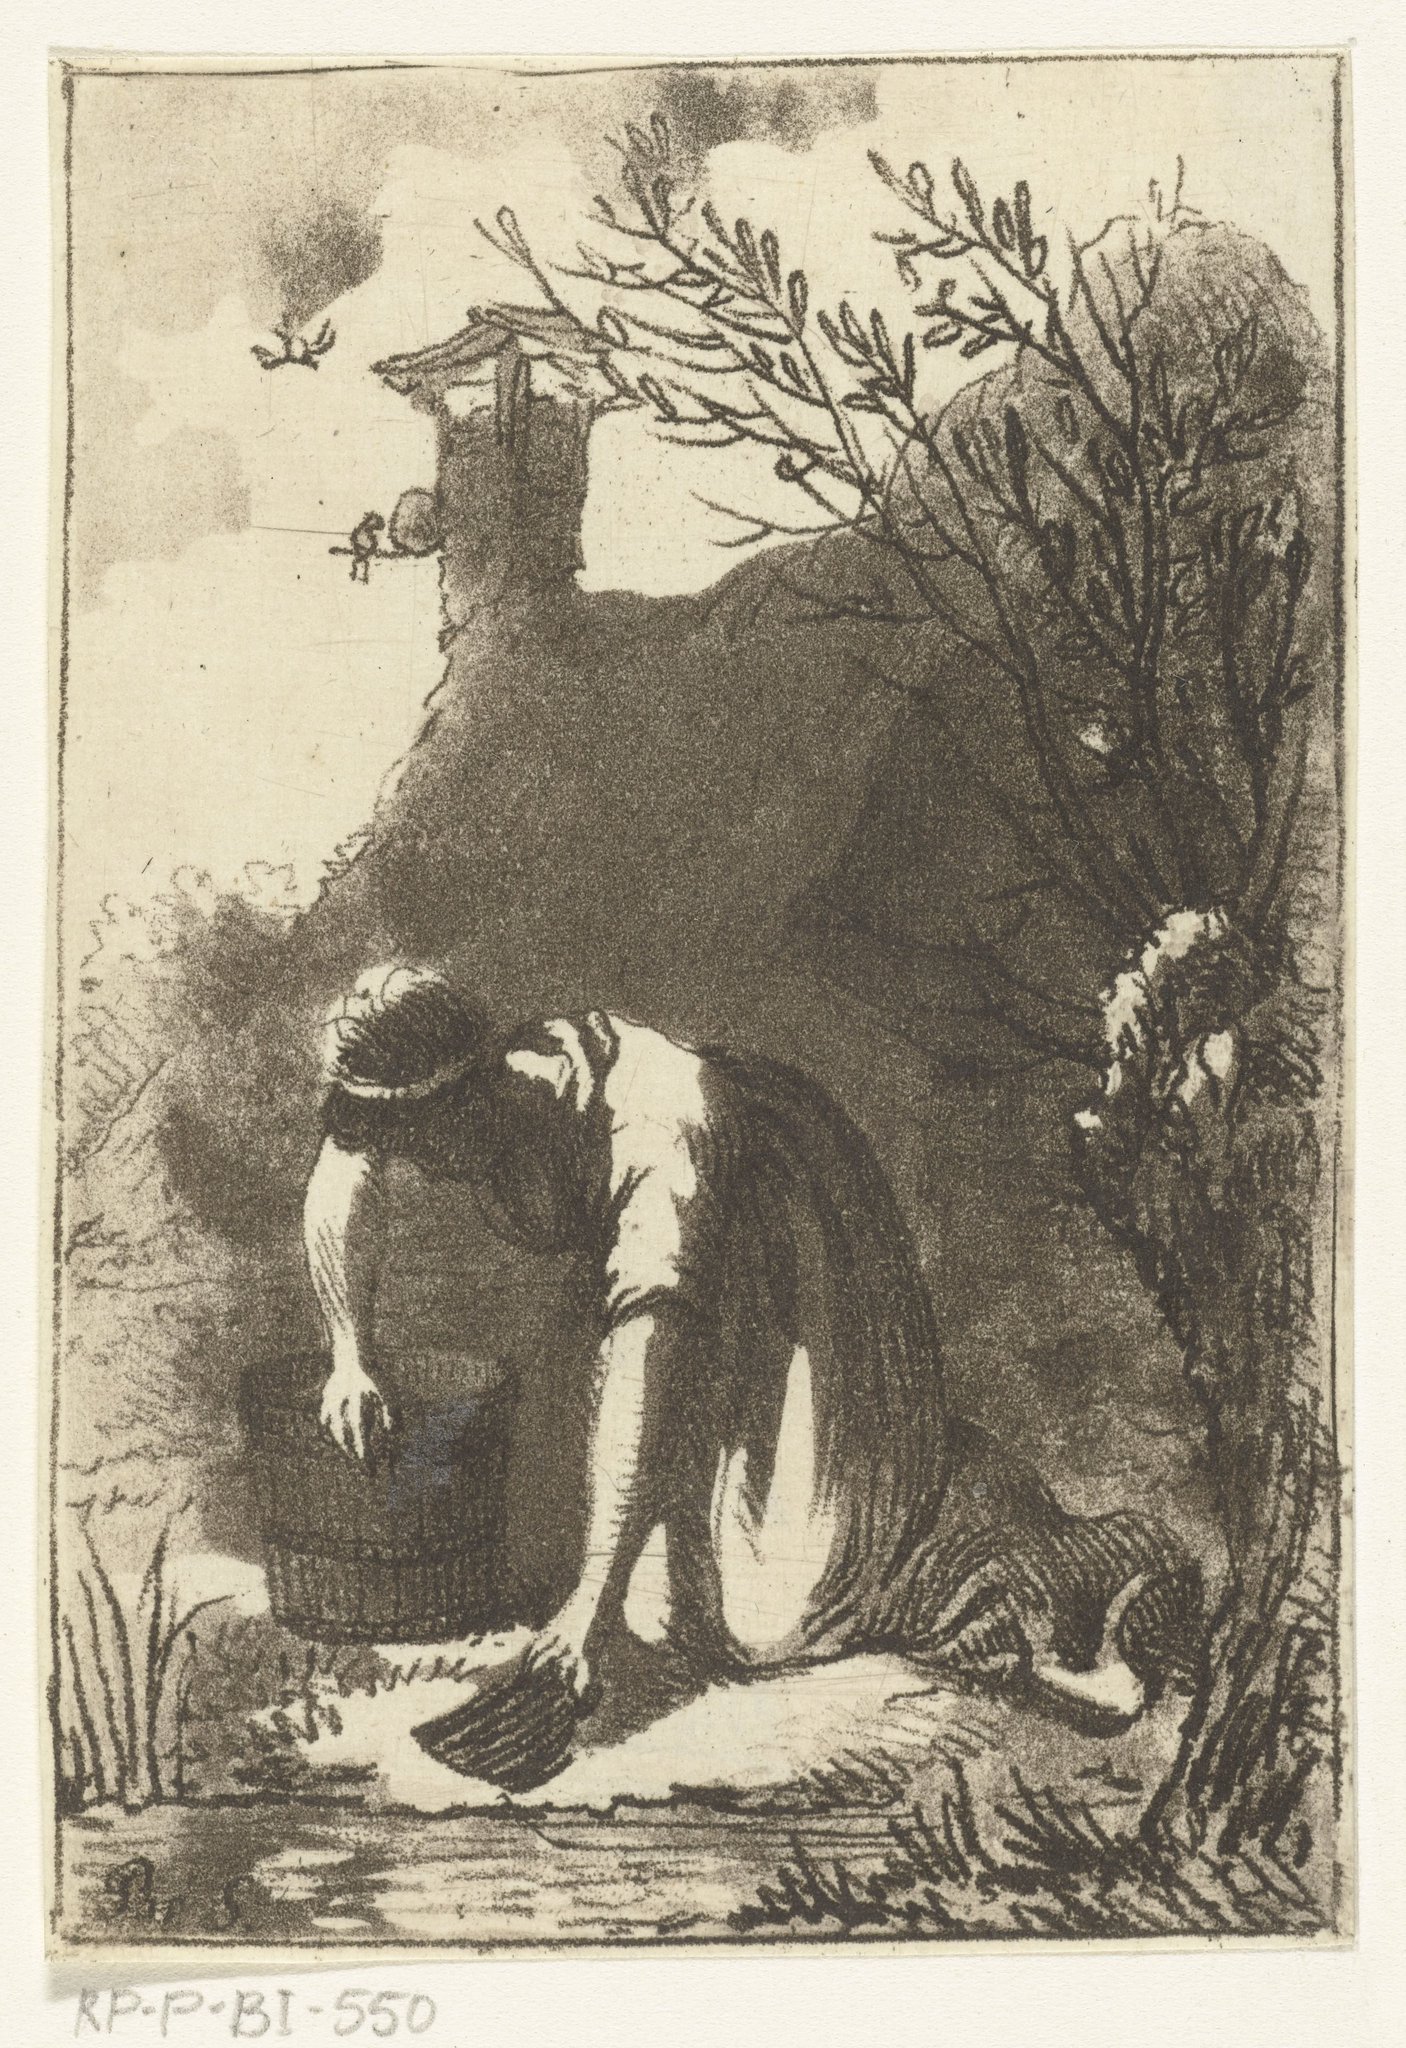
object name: print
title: Vrouw op knieën bij waterkant schept water met kom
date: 1782-1837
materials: paper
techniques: aquatint, soft ground etching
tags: farmers, farm or solitary house in landscape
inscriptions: collector's mark: Lugt 2228